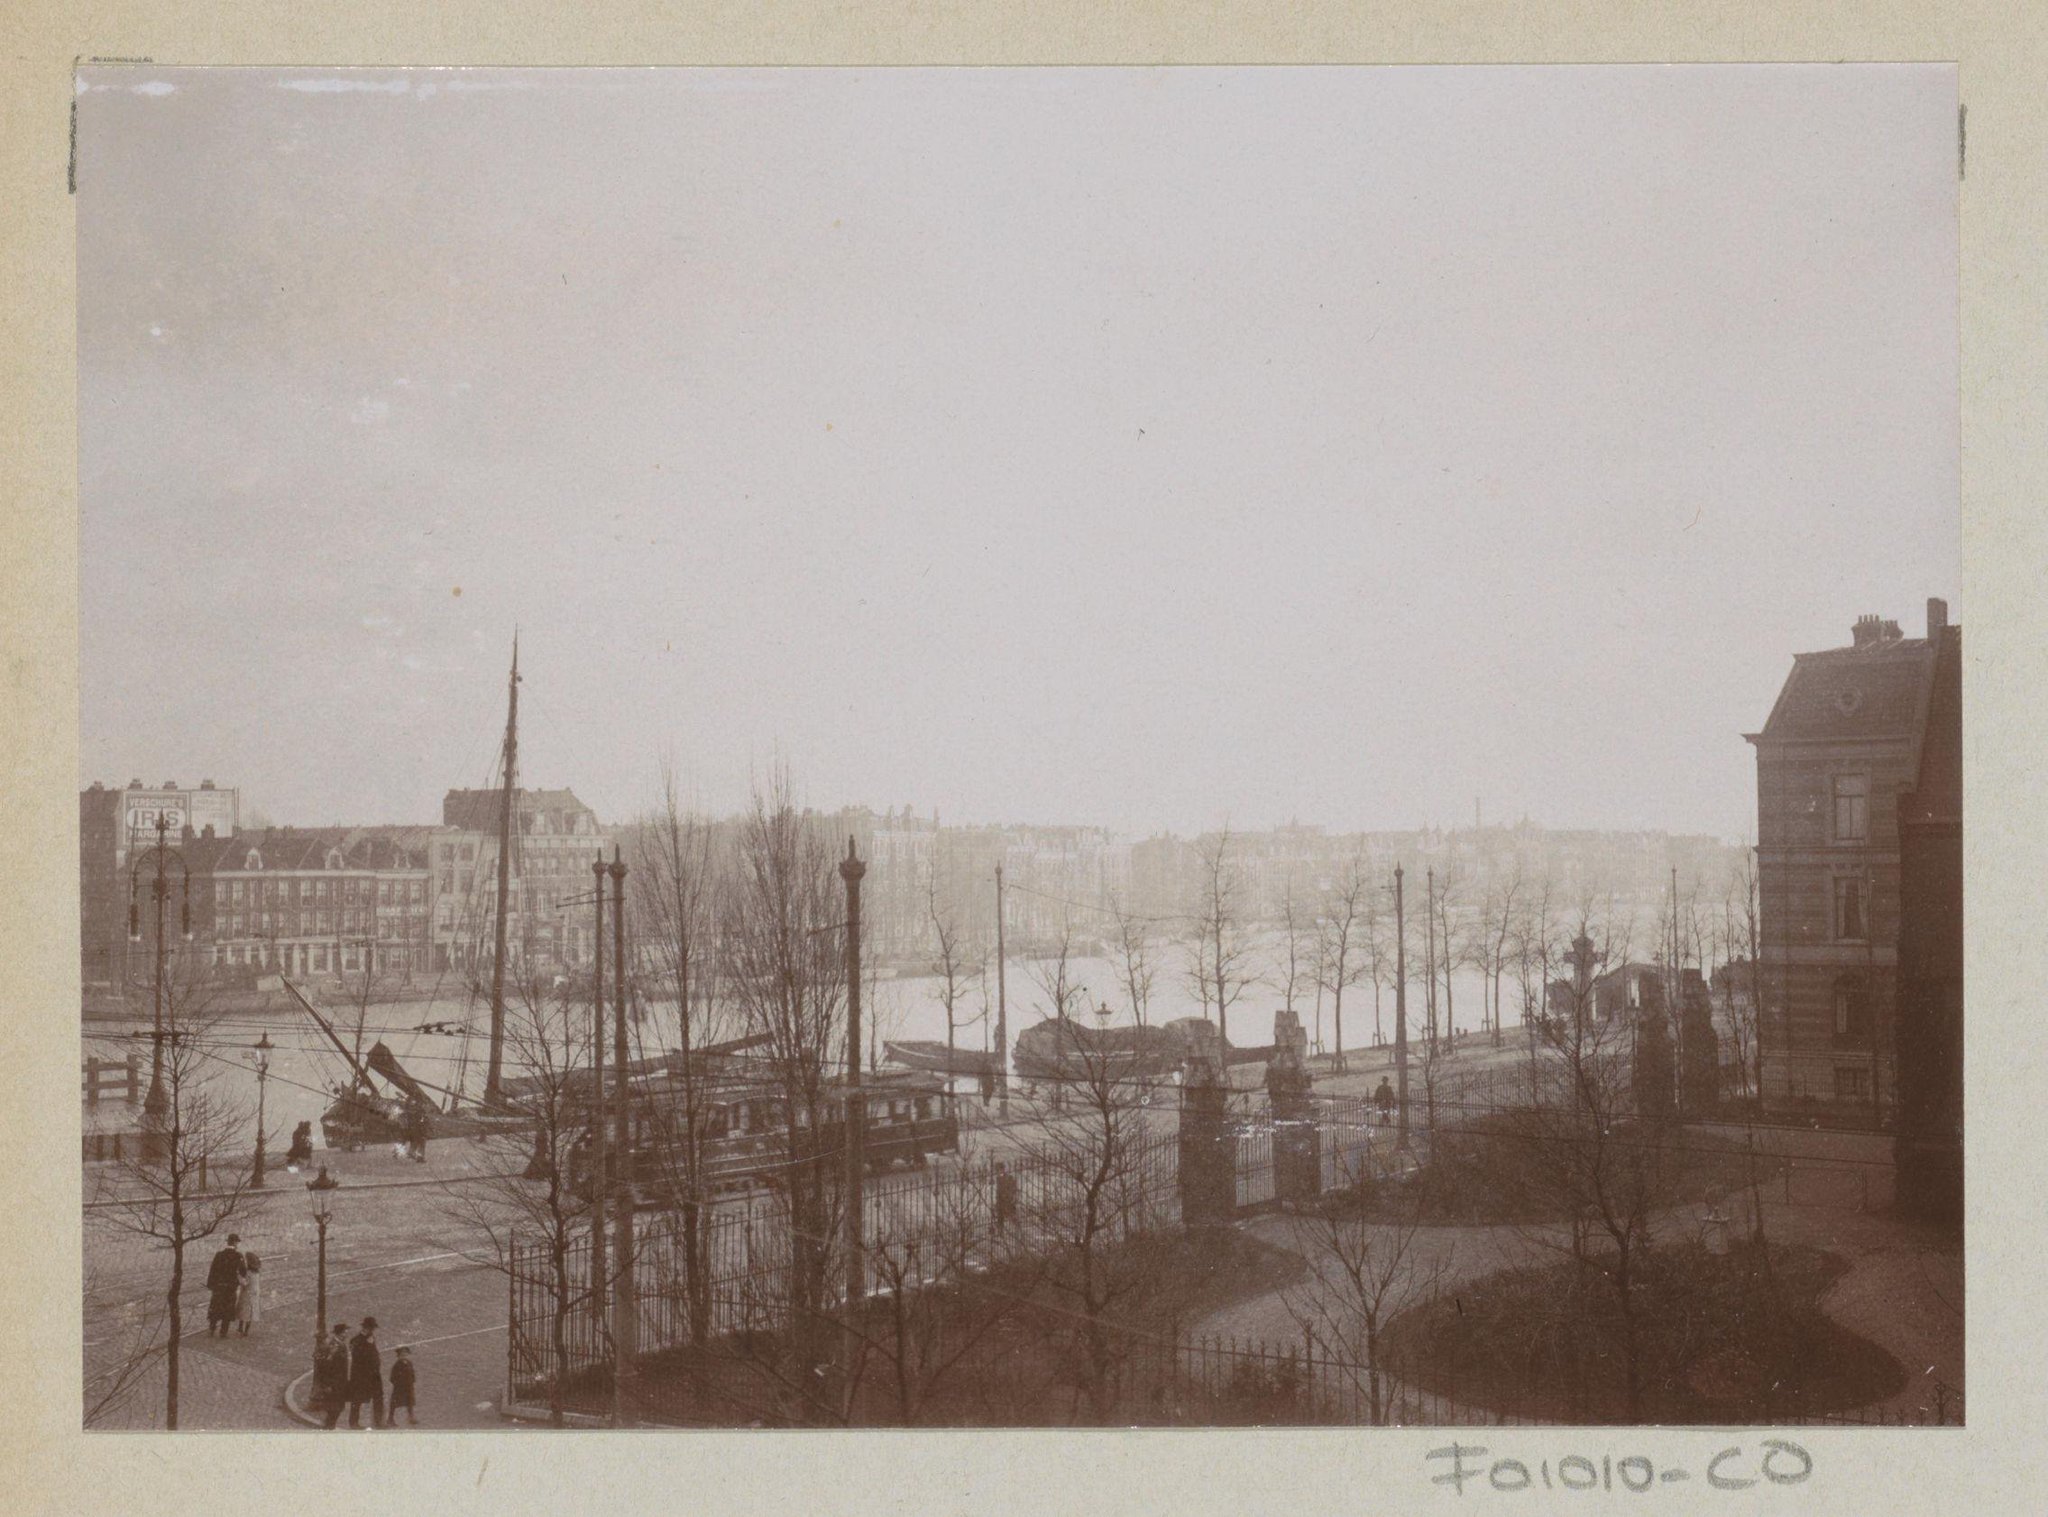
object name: photograph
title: Panoramafoto van de Weesperzijde en de Amsteldijk in Amsterdam, ten zuiden van de Nieuwe Amstelbrug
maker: Anonymous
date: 1903-1910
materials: photographic support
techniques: collodion silver print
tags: tramway, tram, river, pier, quay, wharf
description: Onderdeel van Familiealbum met onder meer foto's van Wijnhandel Kraaij & Co. Bordeaux-Amsterdam.